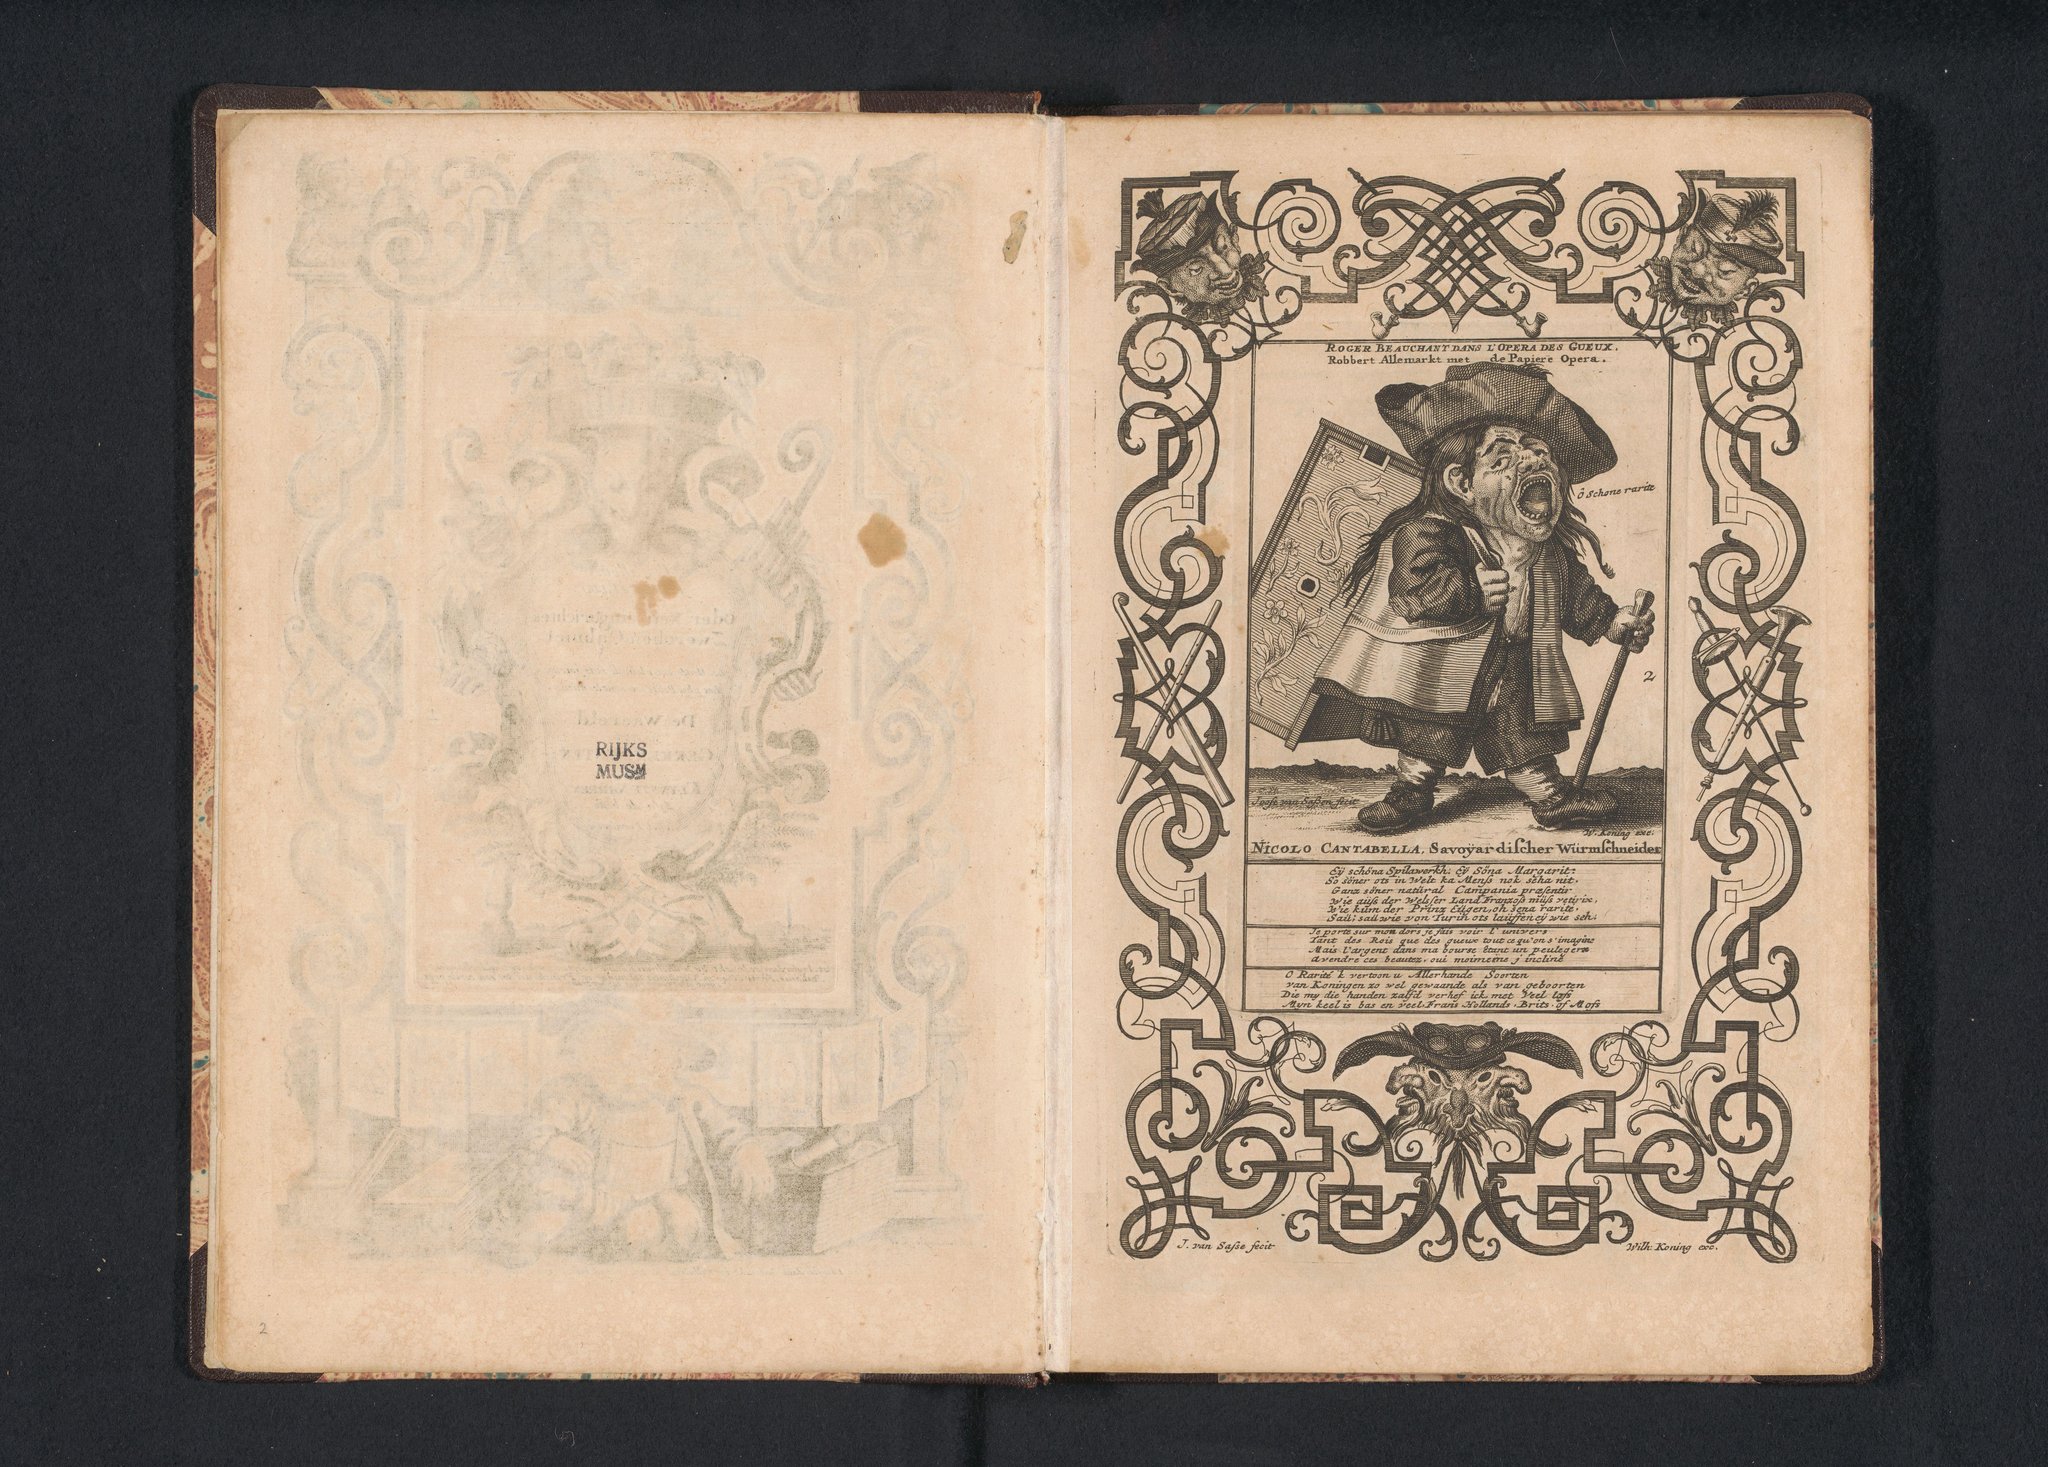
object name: caricature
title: Roger Beauchant dans l'opera des gueux / Robbert Allemarkt met de Papiere Opera / Nicolo Cantabella, Savoyardischer Würmschneider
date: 1716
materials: paper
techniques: etching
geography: amsterdam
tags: caricatures (human types), little people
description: Roepende kleine mens Robbert Allemarkt uit Savoye met een kijkkast op de rug. In het onderschrift verzen in het Duits, Frans en Nederlands. Afdruk binnen een decoratieve omlijsting gedrukt van een aparte plaat met Chinese koppen en een masker. Genummerd rechts midden: 2. Onderdeel van de Nederlandse gebonden uitgave uit 1716 van een serie karikaturen van kleine mensen, bekend als Het Dwergentooneel, gekopieerd naar een ouder Duits voorbeeld.